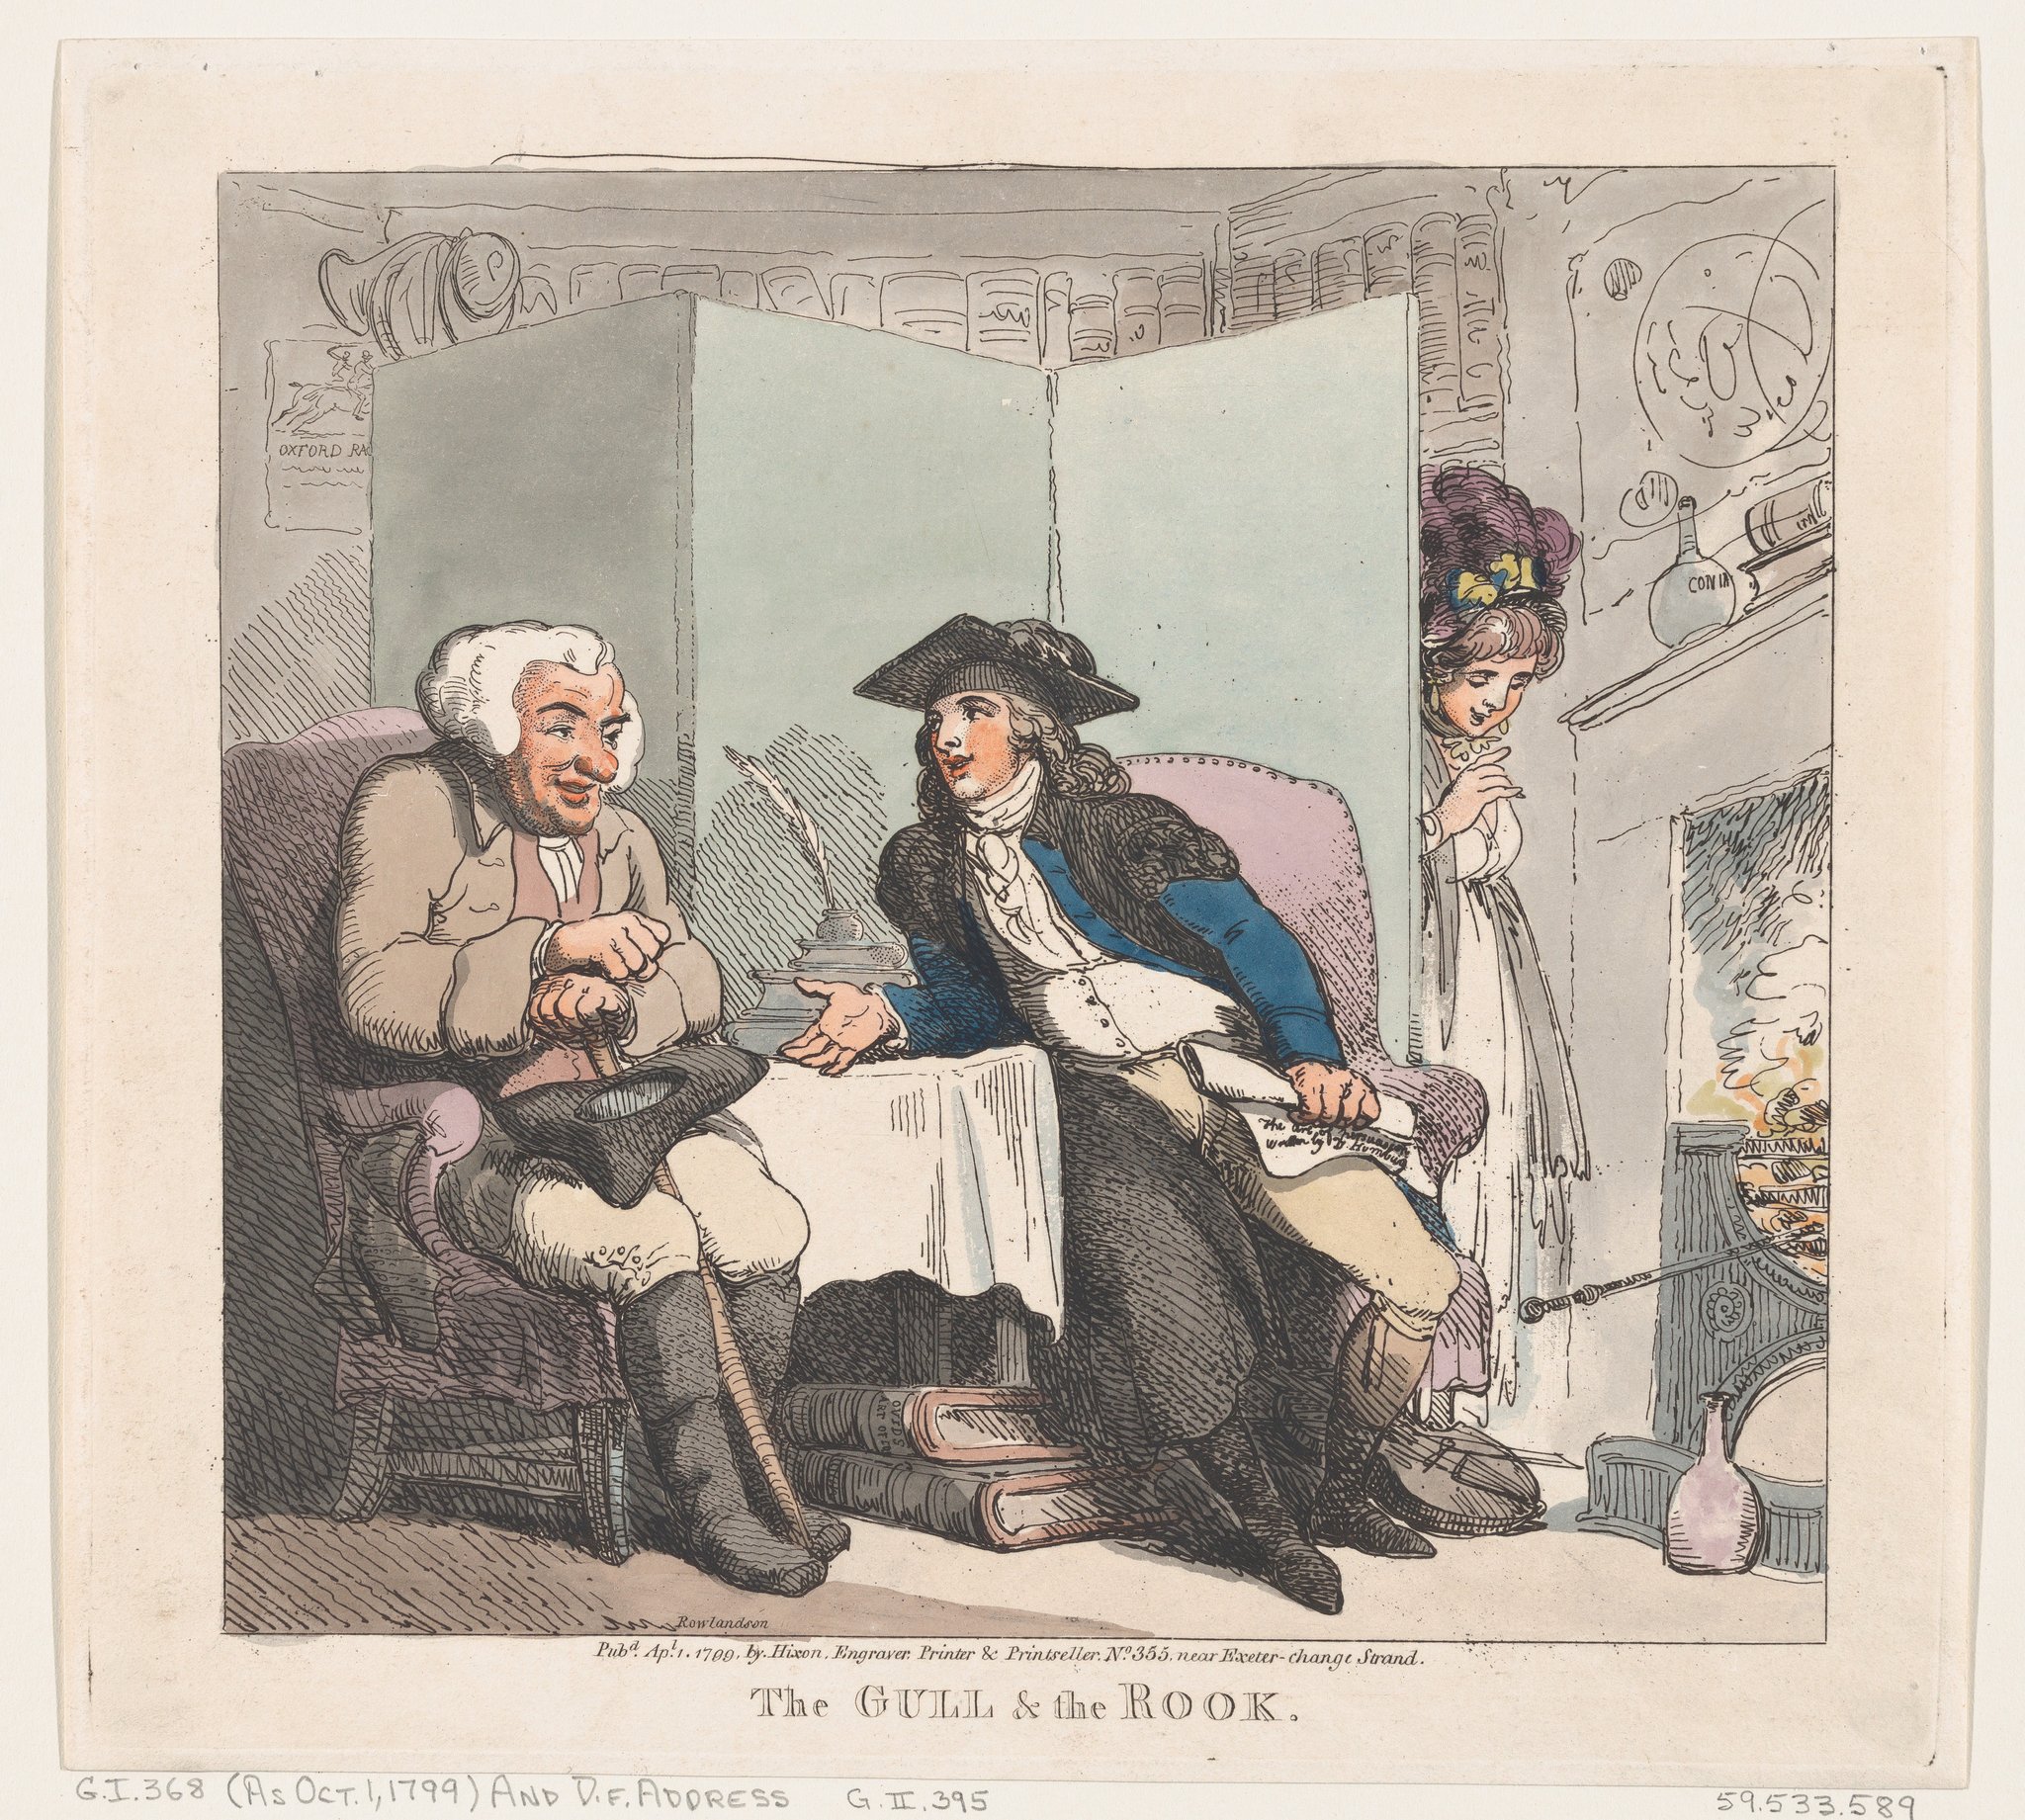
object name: print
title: The Gull and the Rook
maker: thomas rowlandson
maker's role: artist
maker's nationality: british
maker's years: 1757-1827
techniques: etching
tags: satire,men,women